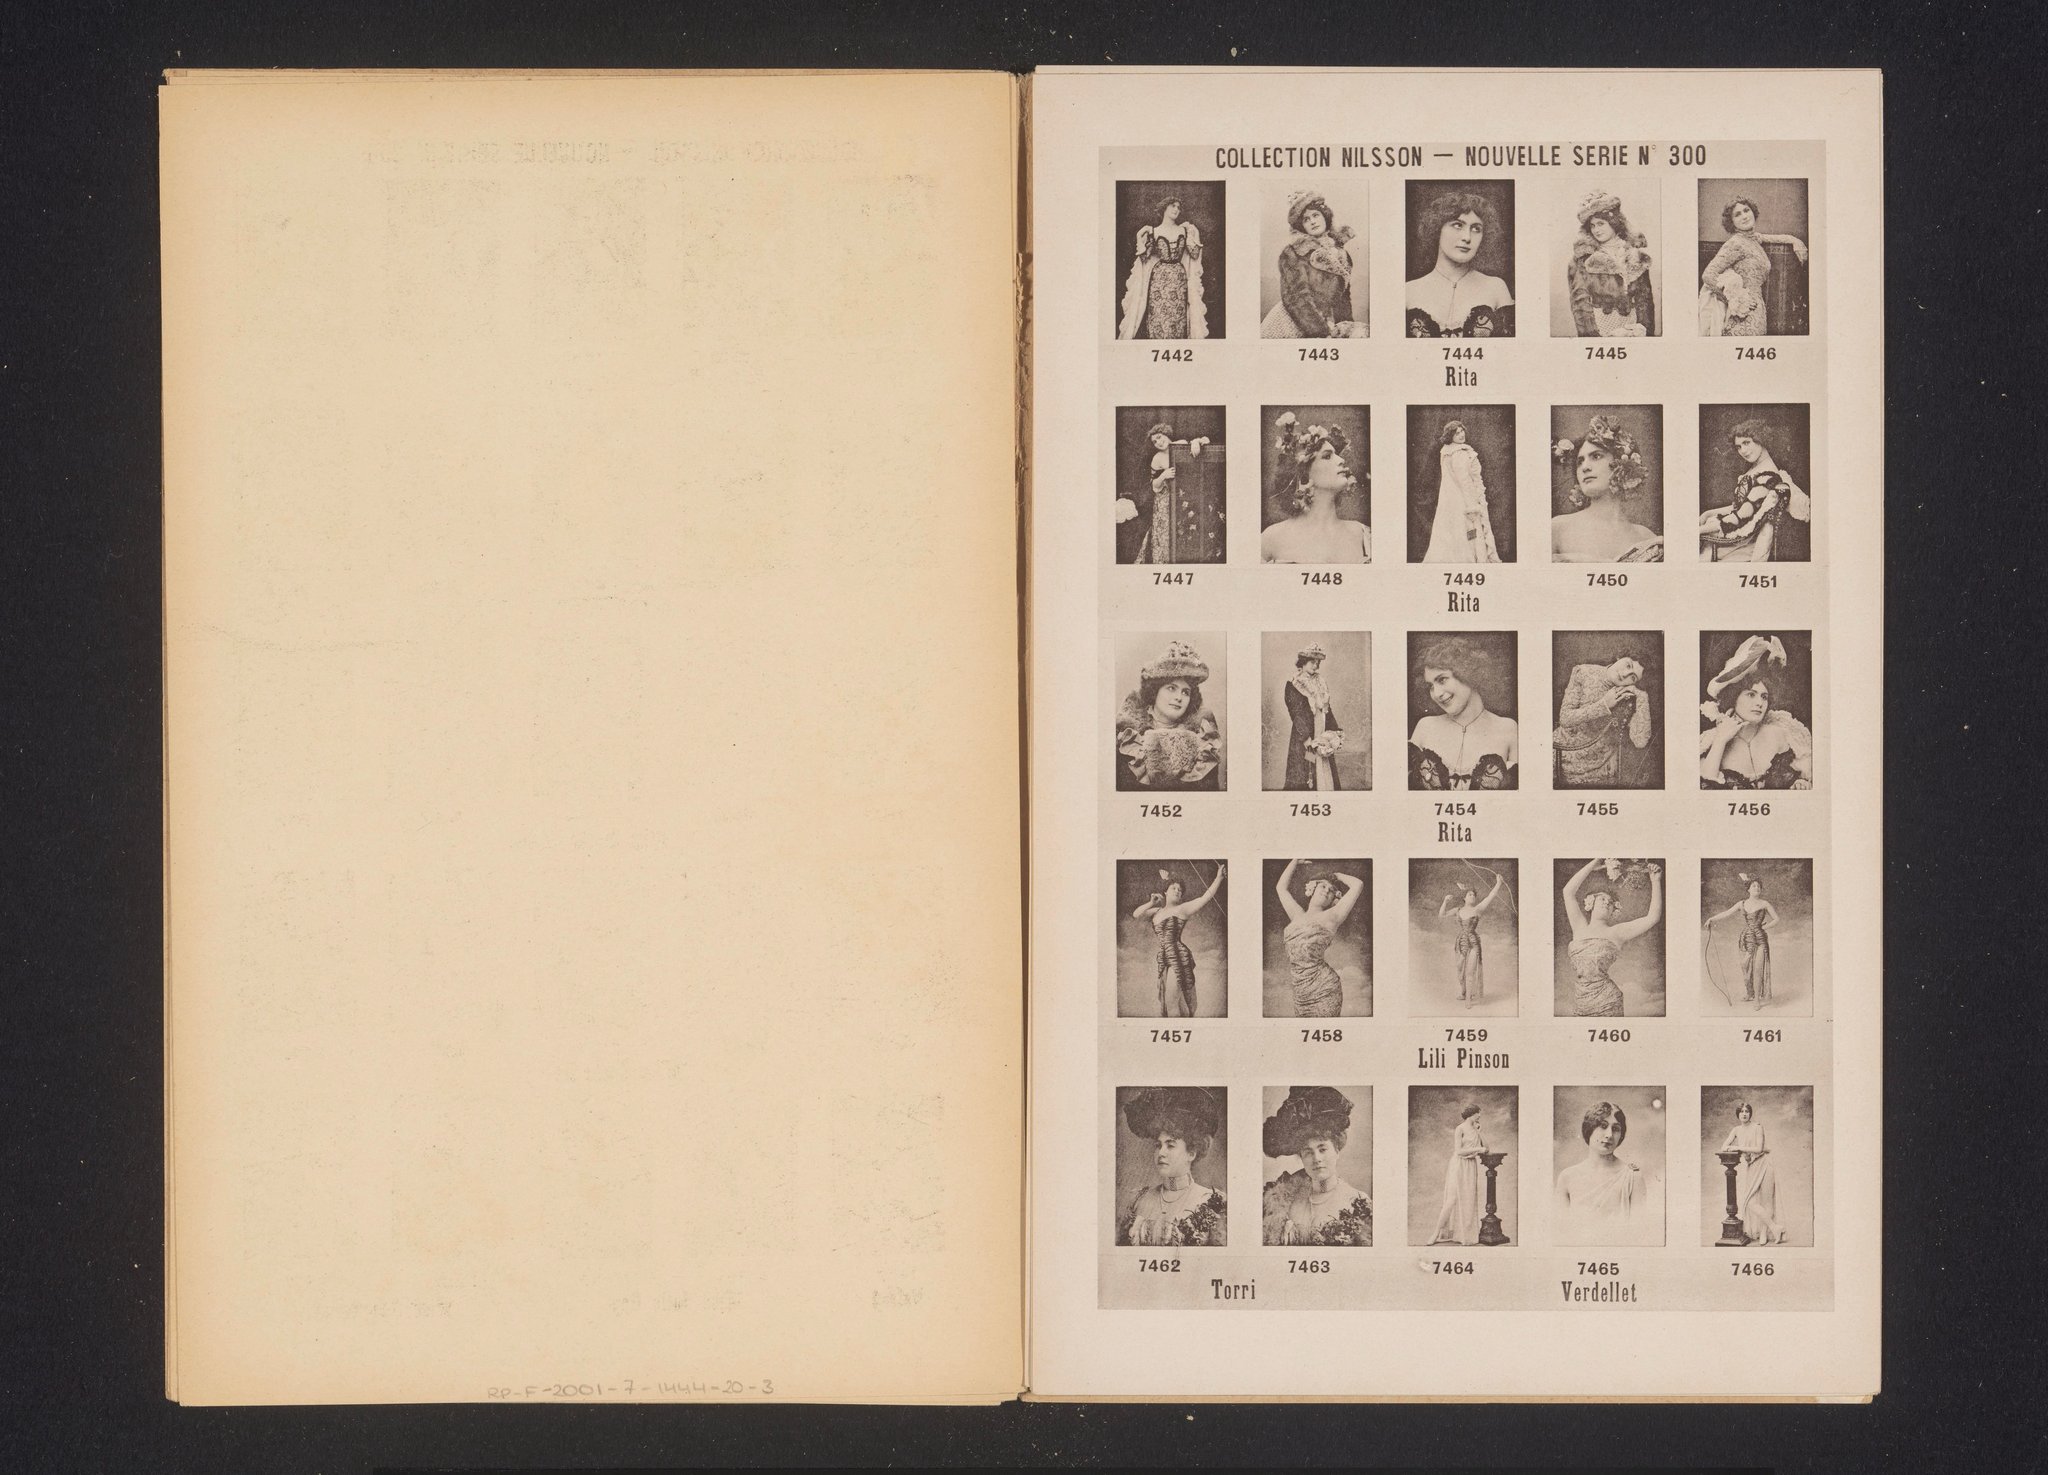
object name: page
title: 25 portretten van Rita, Lili Pinson, Torri en Verdellet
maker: Anonymous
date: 1895-1900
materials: paper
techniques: photograph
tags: historical persons - bb - woman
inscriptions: number: ‘No 300’